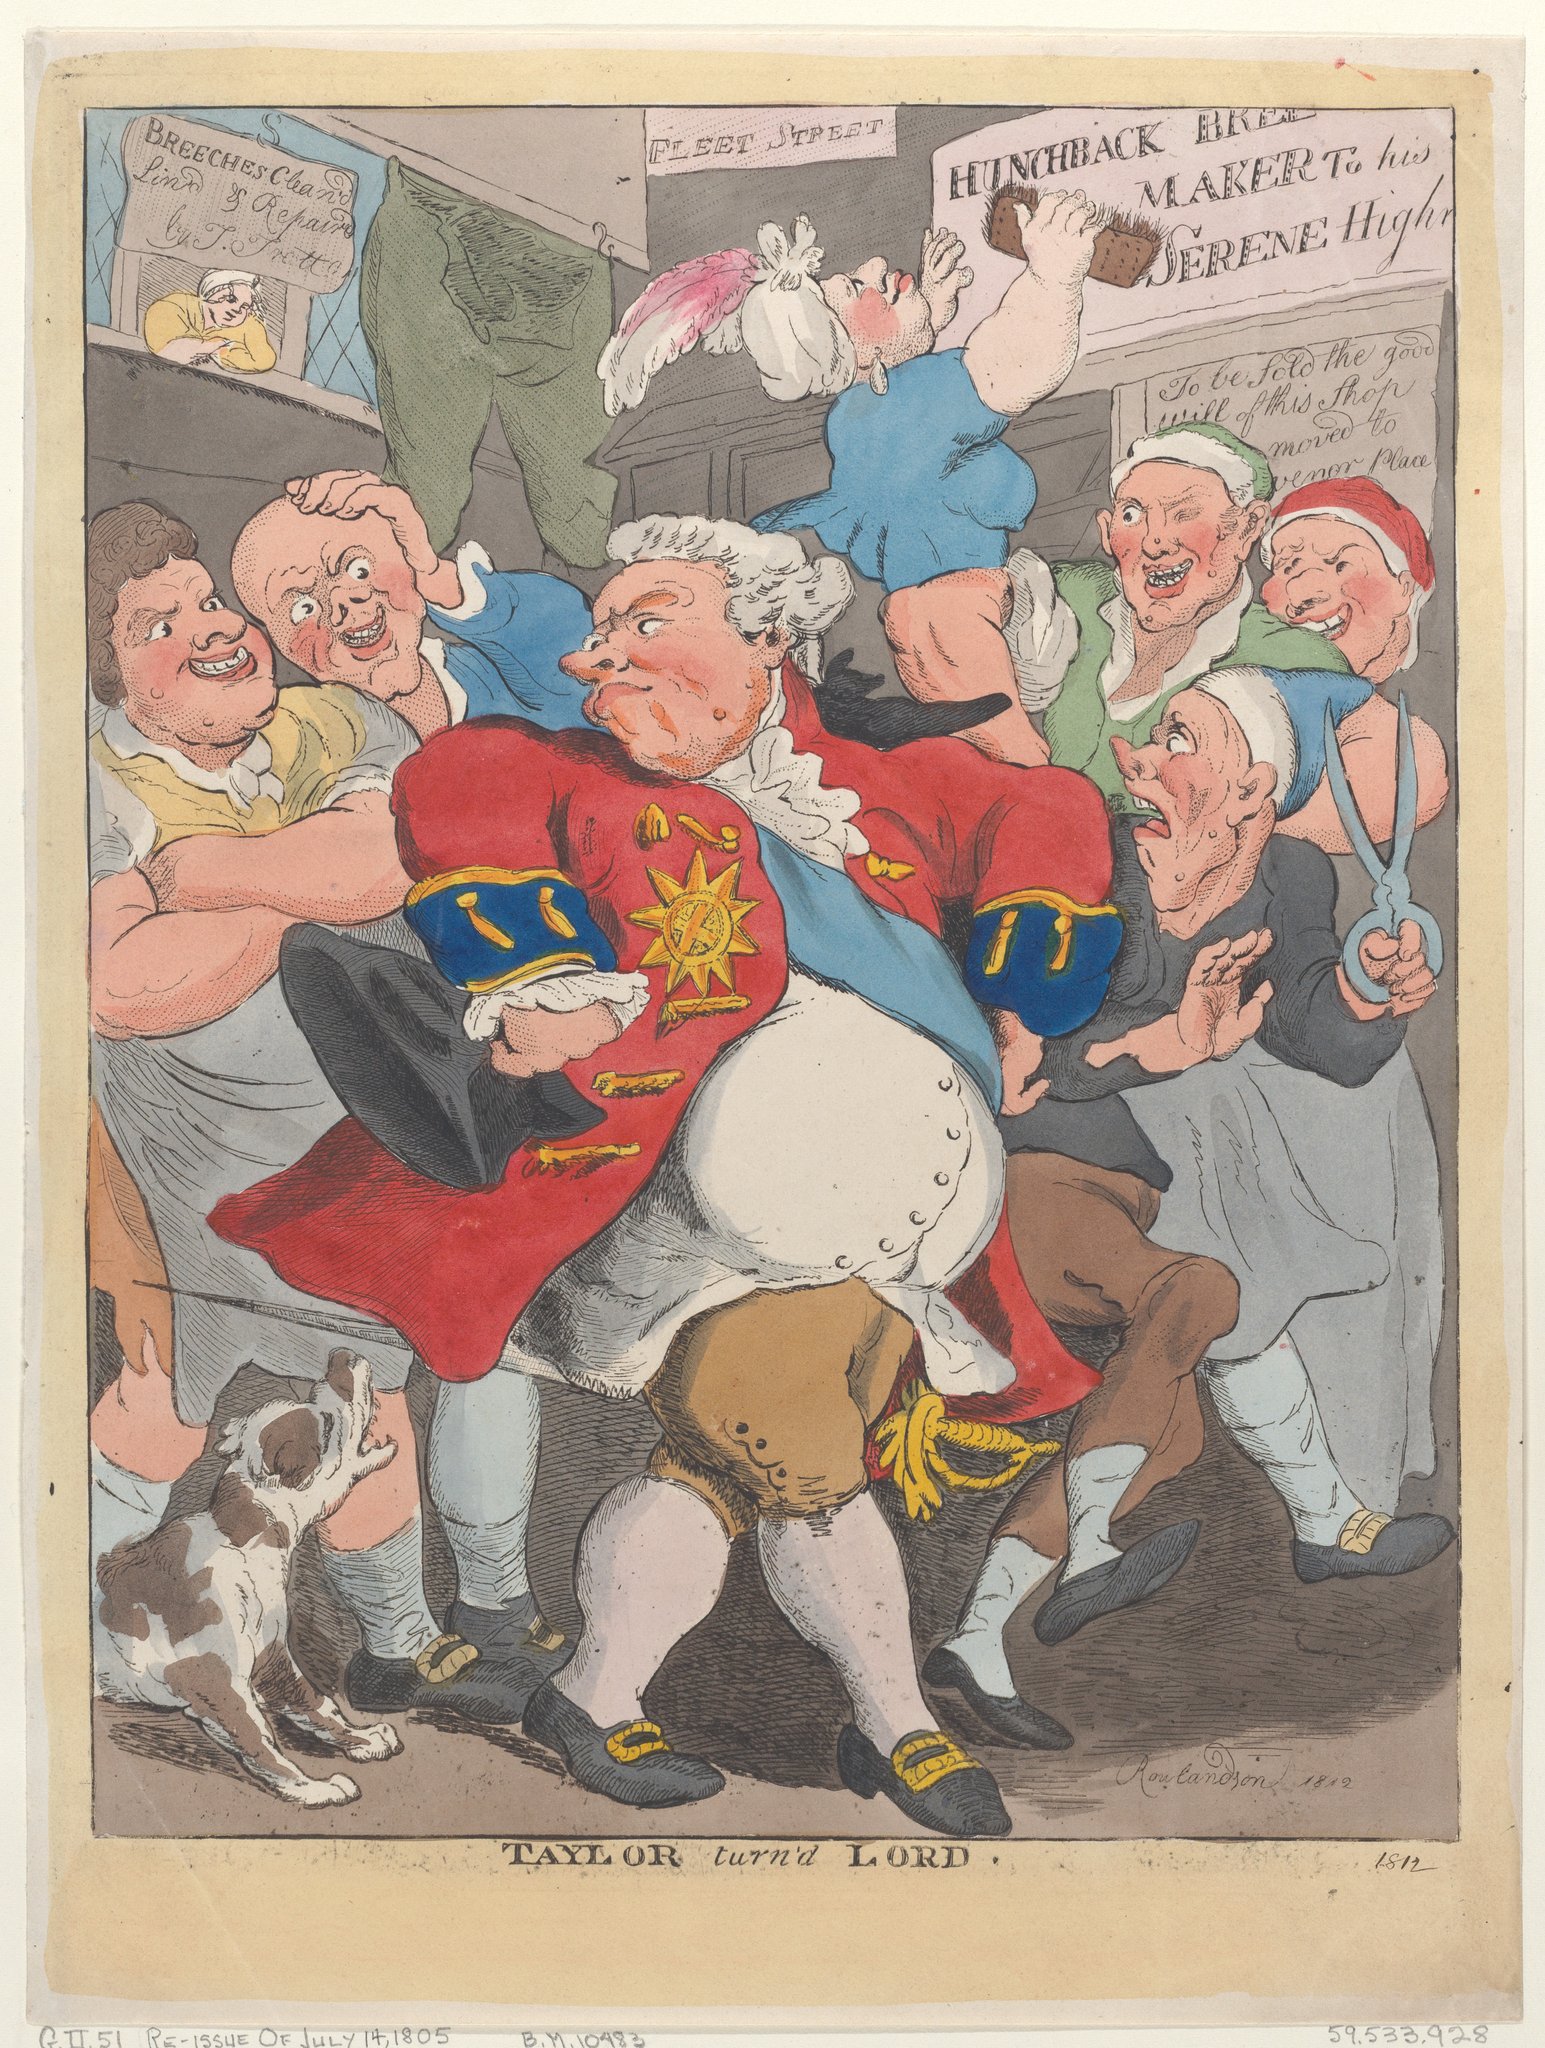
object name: print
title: Taylor turn'd Lord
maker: thomas rowlandson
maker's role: artist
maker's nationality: british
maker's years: 1757-1827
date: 1812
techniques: etching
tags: satire,men,women,dogs